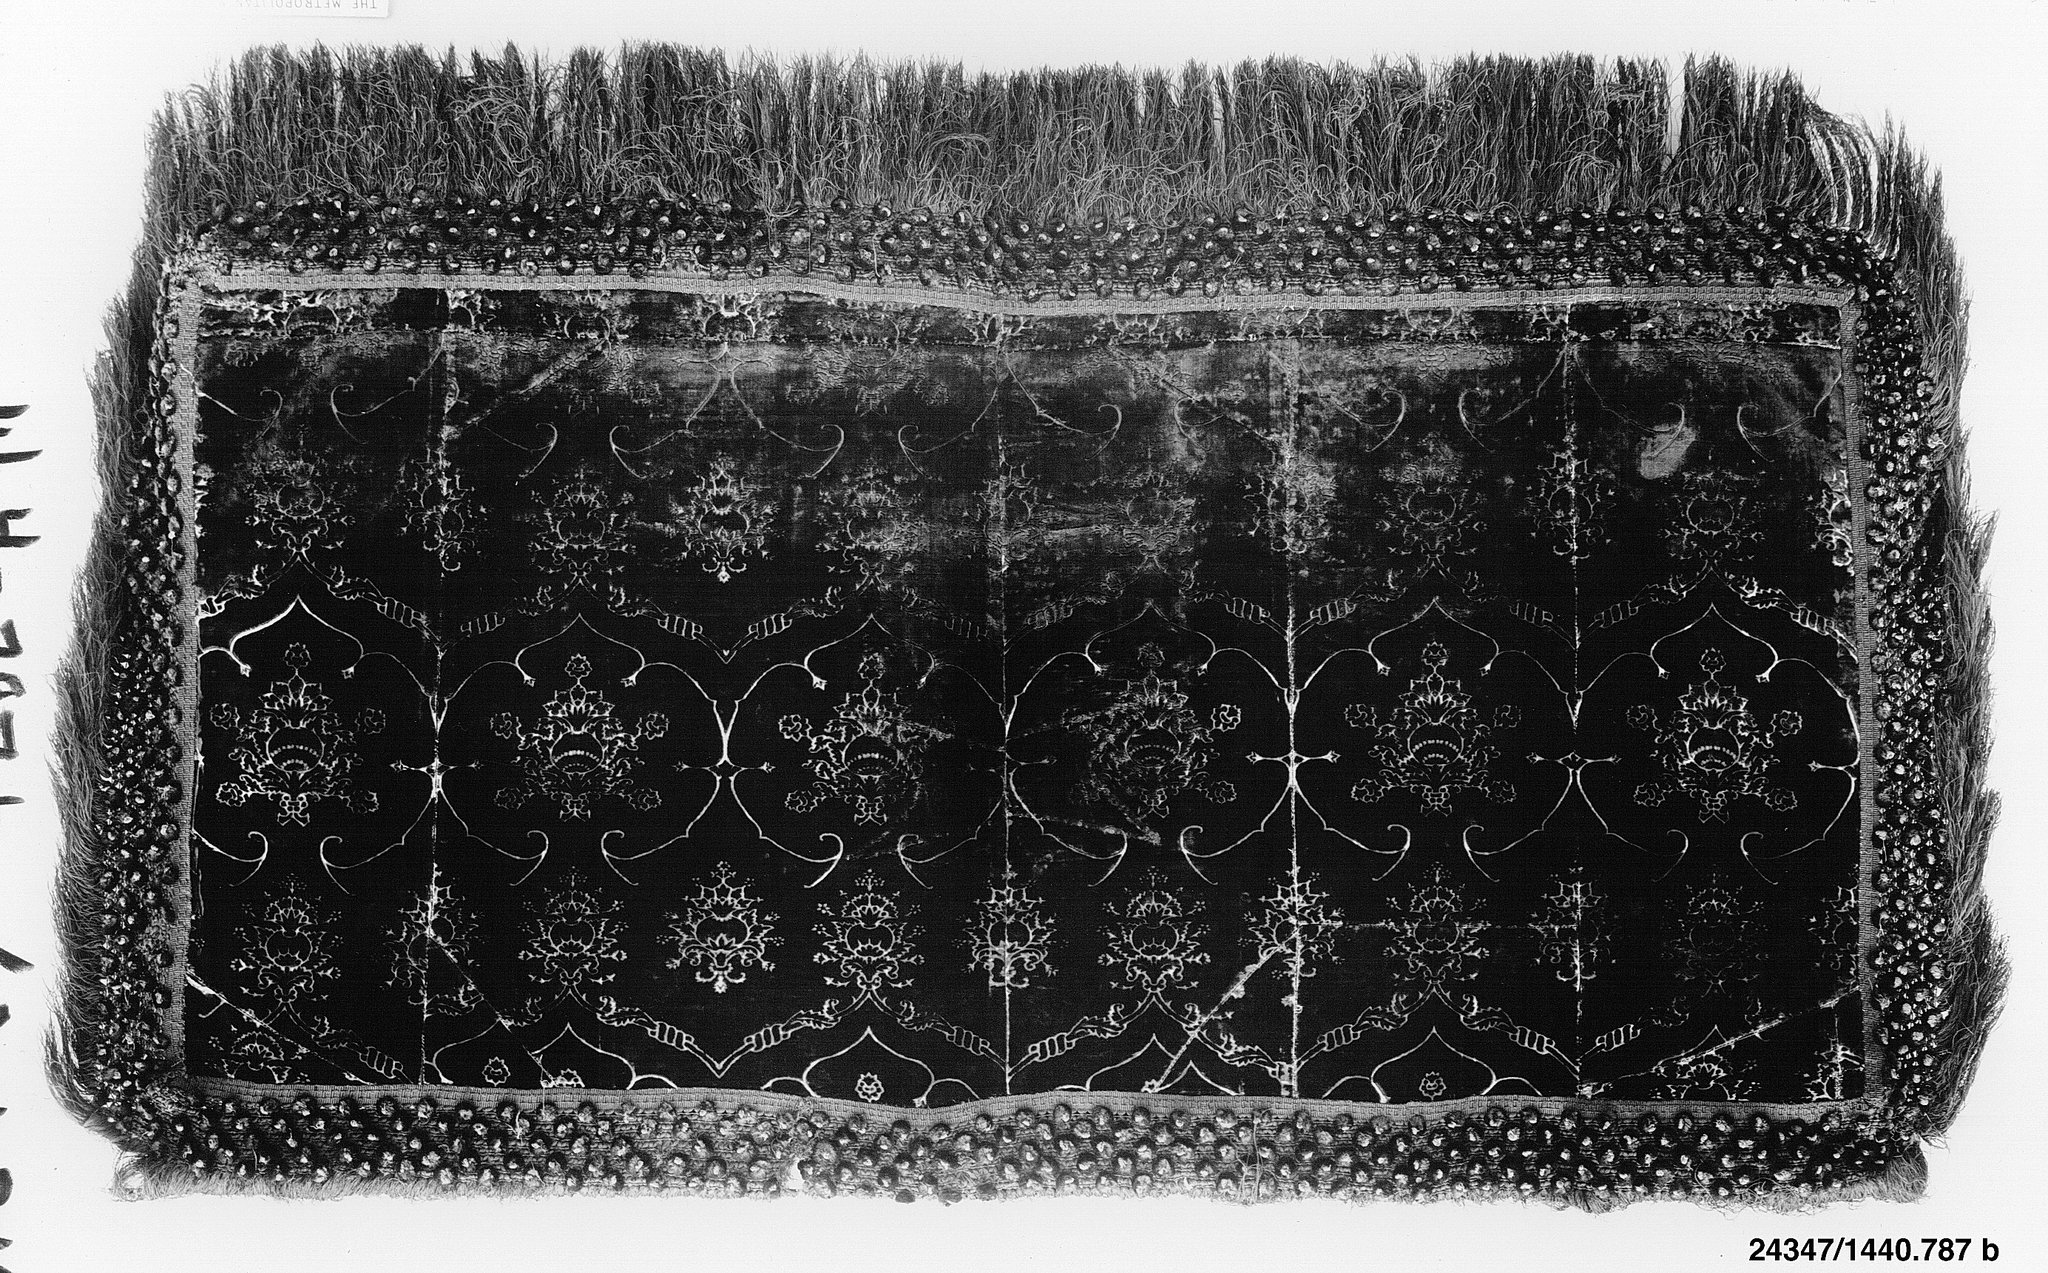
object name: table cover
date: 1401-1500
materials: silk